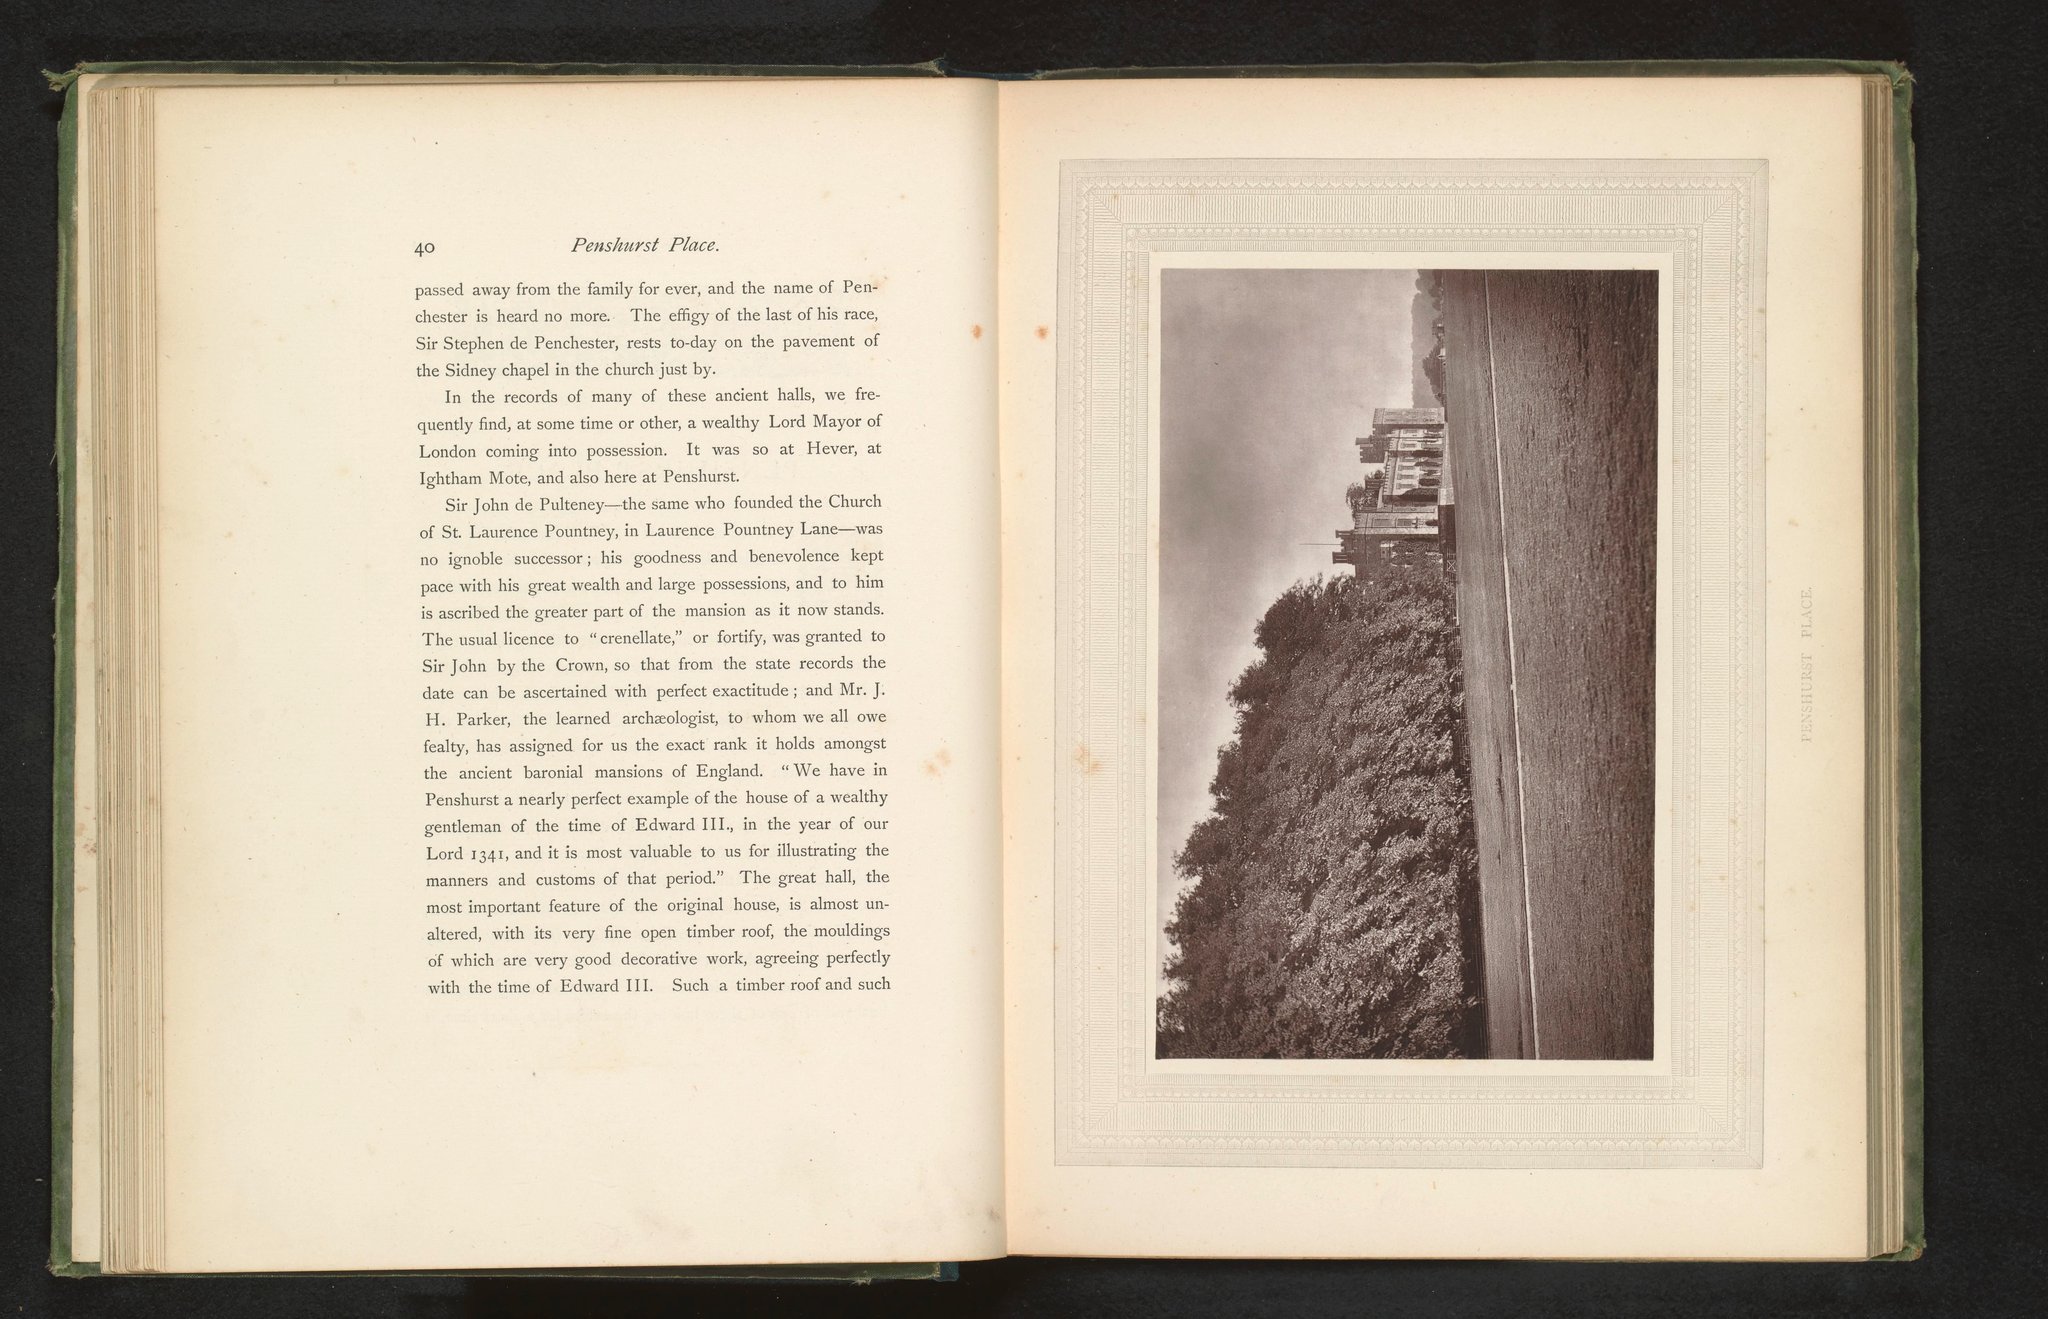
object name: page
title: Gezicht op Penshurst Place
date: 1866-1876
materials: paper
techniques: woodburytype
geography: penshurst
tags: rural housing, e.g. country-house, villa, cottage